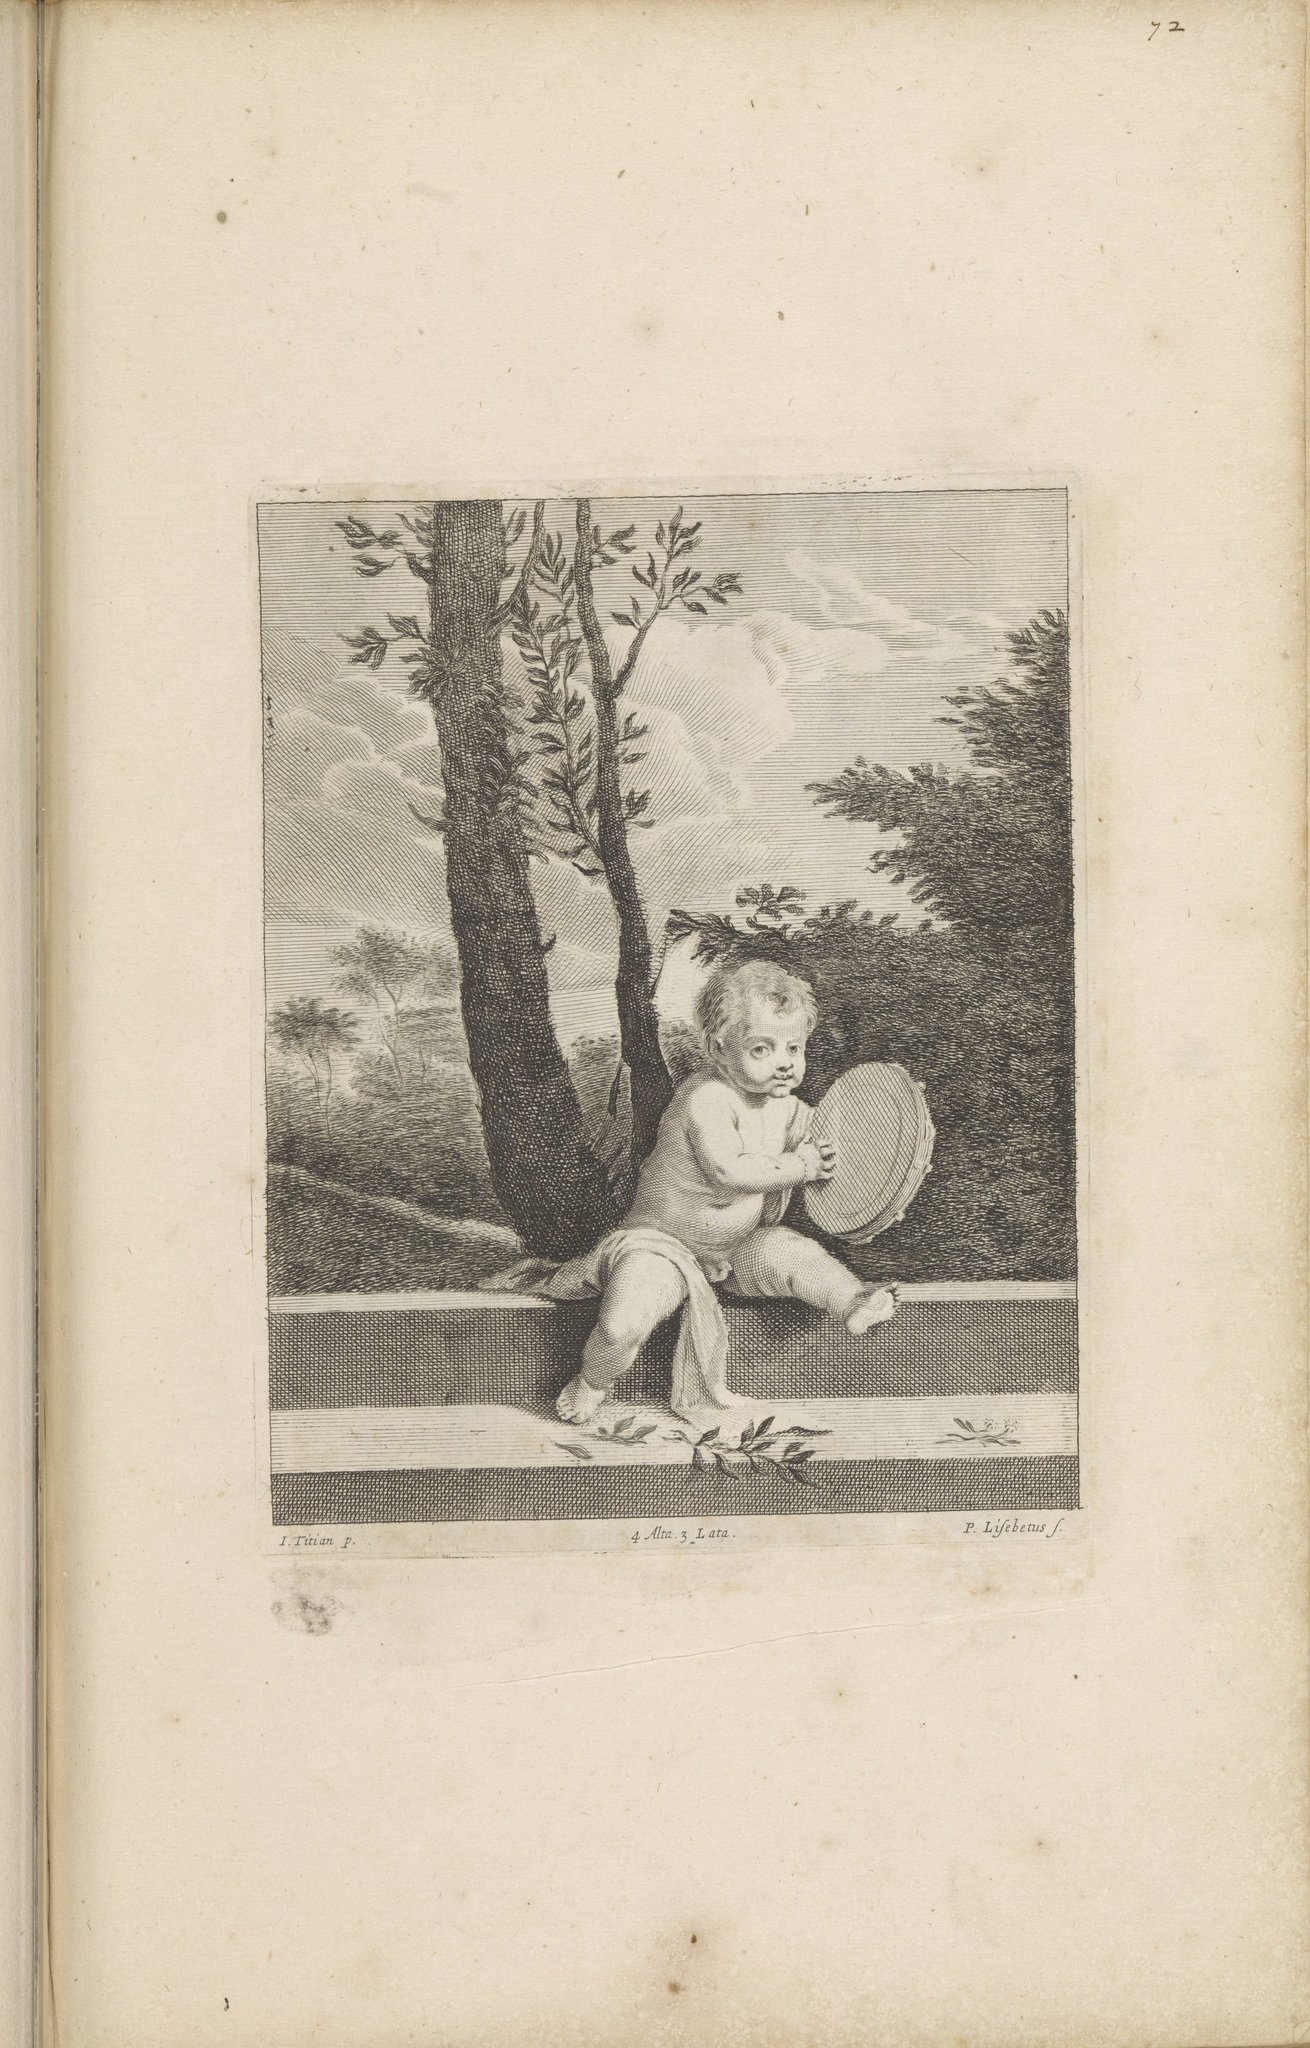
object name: album leaf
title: Putto met een tamboerijn in een landschap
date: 1660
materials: paper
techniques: engraving, etching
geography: venice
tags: landscapes in the temperate zone, tambourine, cupids: 'amores', 'amoretti', 'putti'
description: De prent is vervaardigd naar een Venetiaans schilderij dat zich in de collectie van het Kunsthistorisches Museum te Wenen bevindt (inventarisnummer GG_96). David Teniers heeft waarschijnlijk van alle schilderijen uit de collectie van Leopold Willem van Oostenrijk een olieverfstudie op doek of paneel vervaardigd (zgn. pasticcio), die als voorbeeld voor de prentmakers diende. Het is niet altijd duidelijk of de pasticci door hem zijn gemaakt of door zijn atelier. Niet alle pasticci zijn overgeleverd.